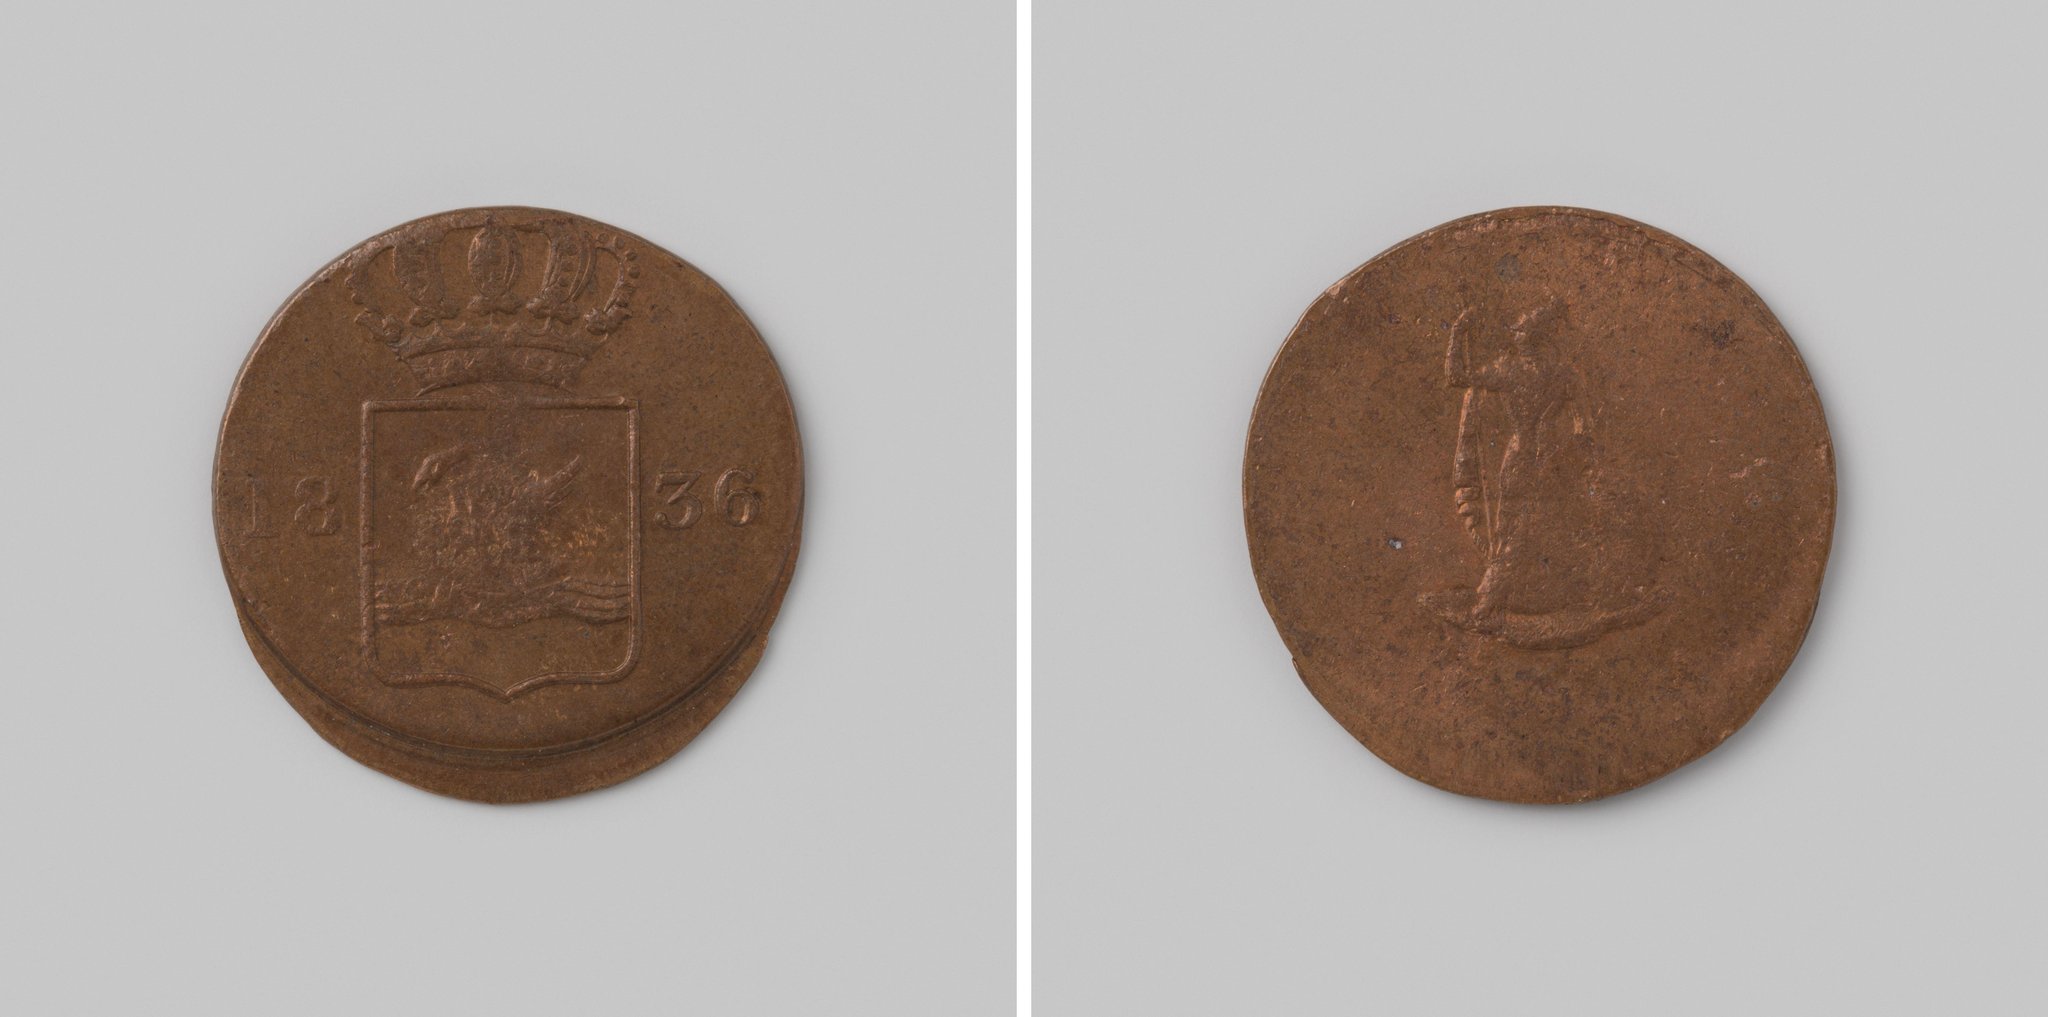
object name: coin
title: Nederlands Indië, zwaantjesduit,1836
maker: Anonymous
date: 1836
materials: copper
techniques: striking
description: Koperen proefmunt. Voorzijde: tussen jaartal gekroond wapenschild, waarin zwaan. Keerzijde: Pallas-figuur. Gladde rand.